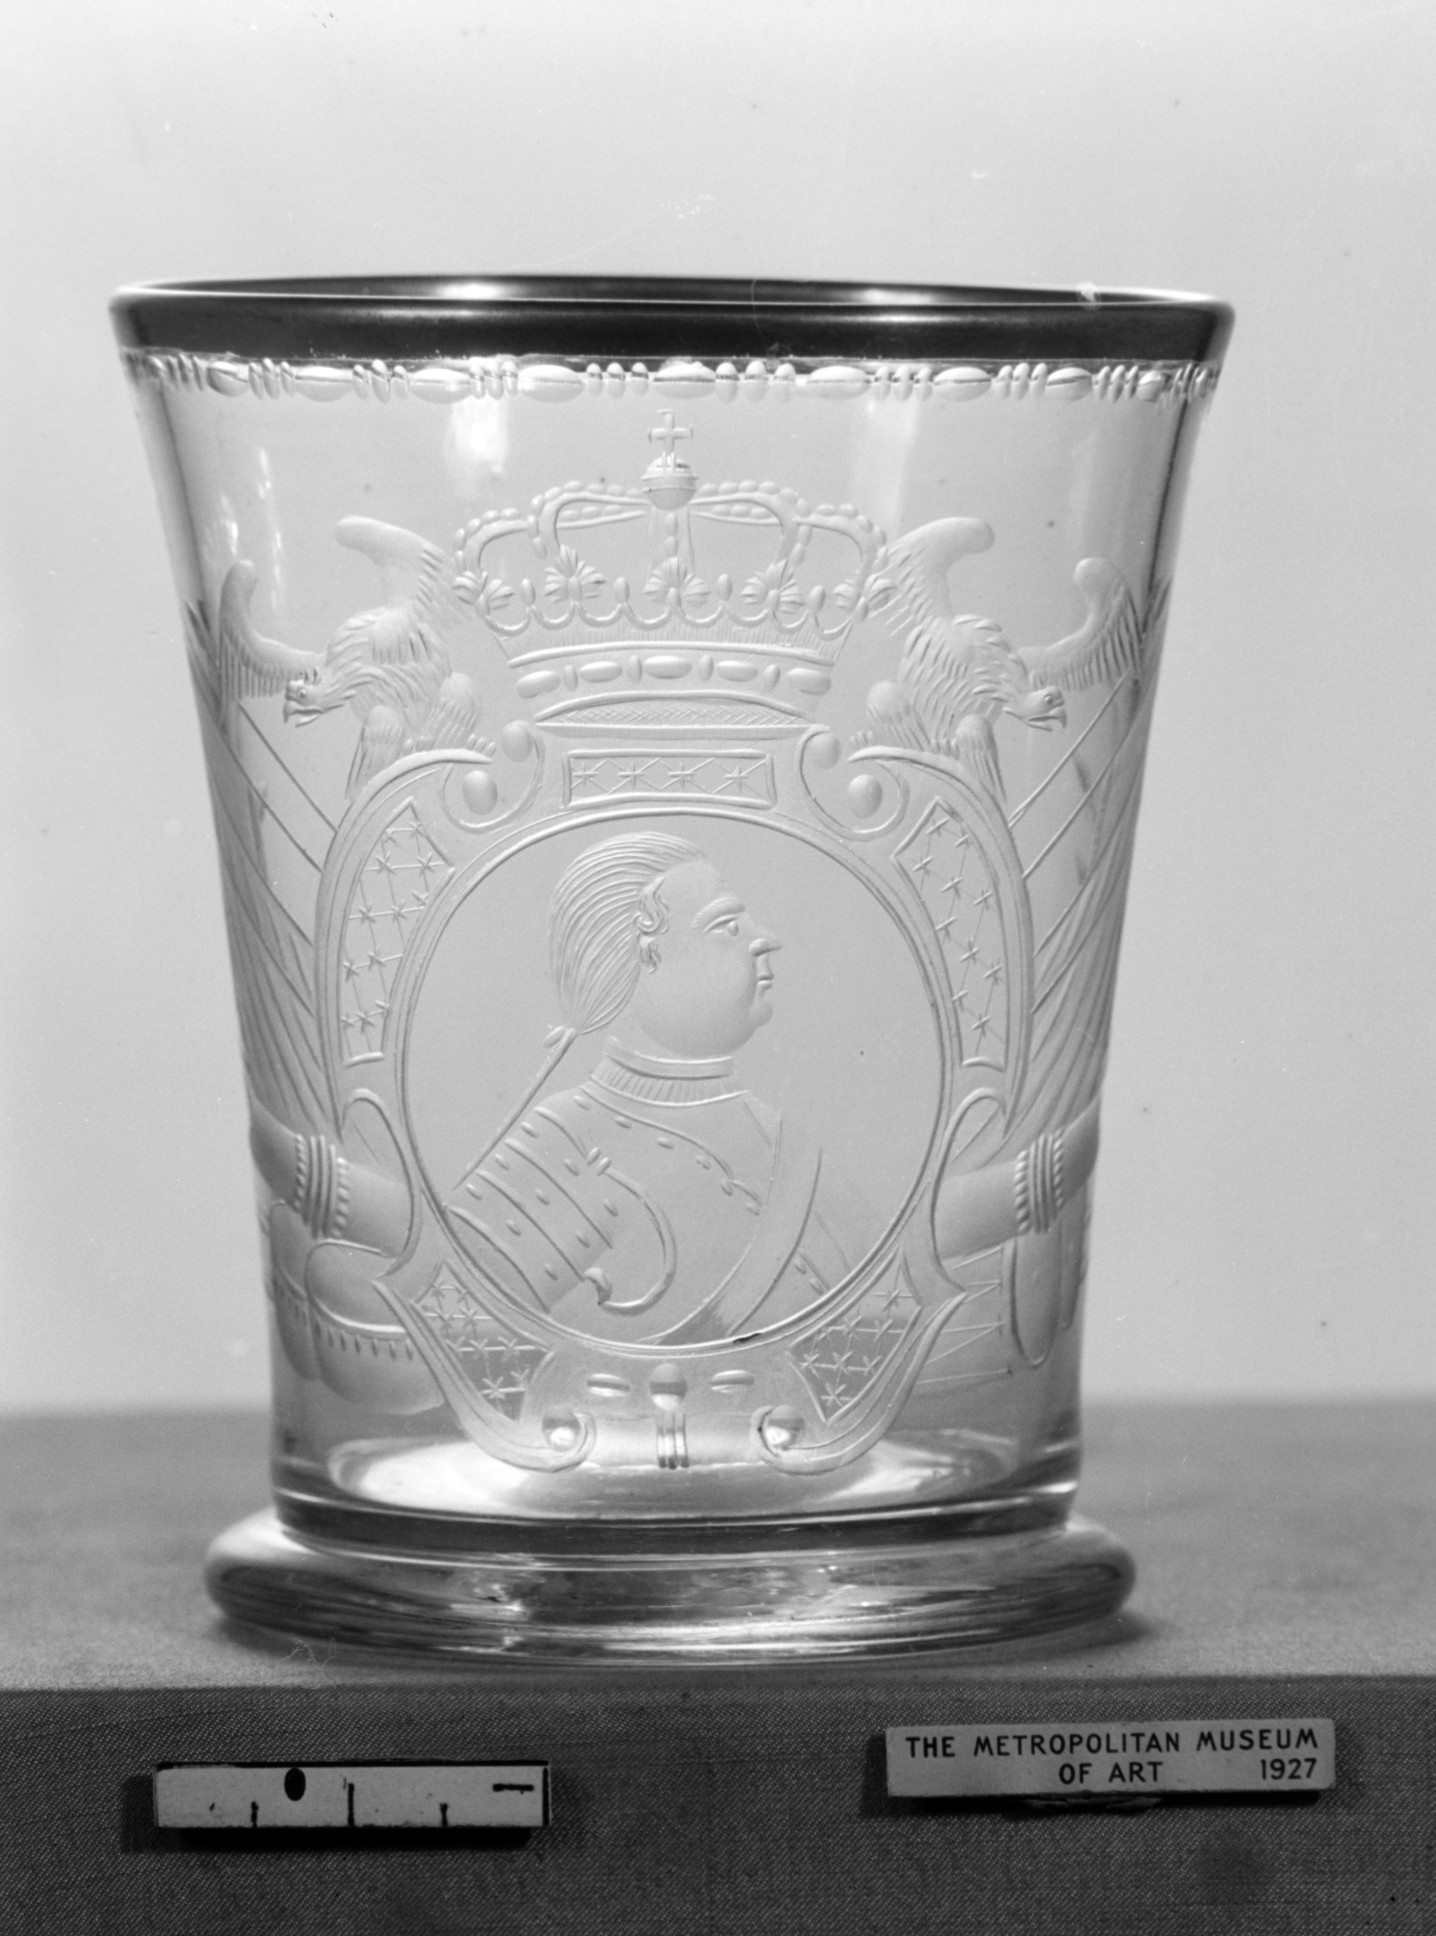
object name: beaker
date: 1701-1800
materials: glass, silver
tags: men,profiles